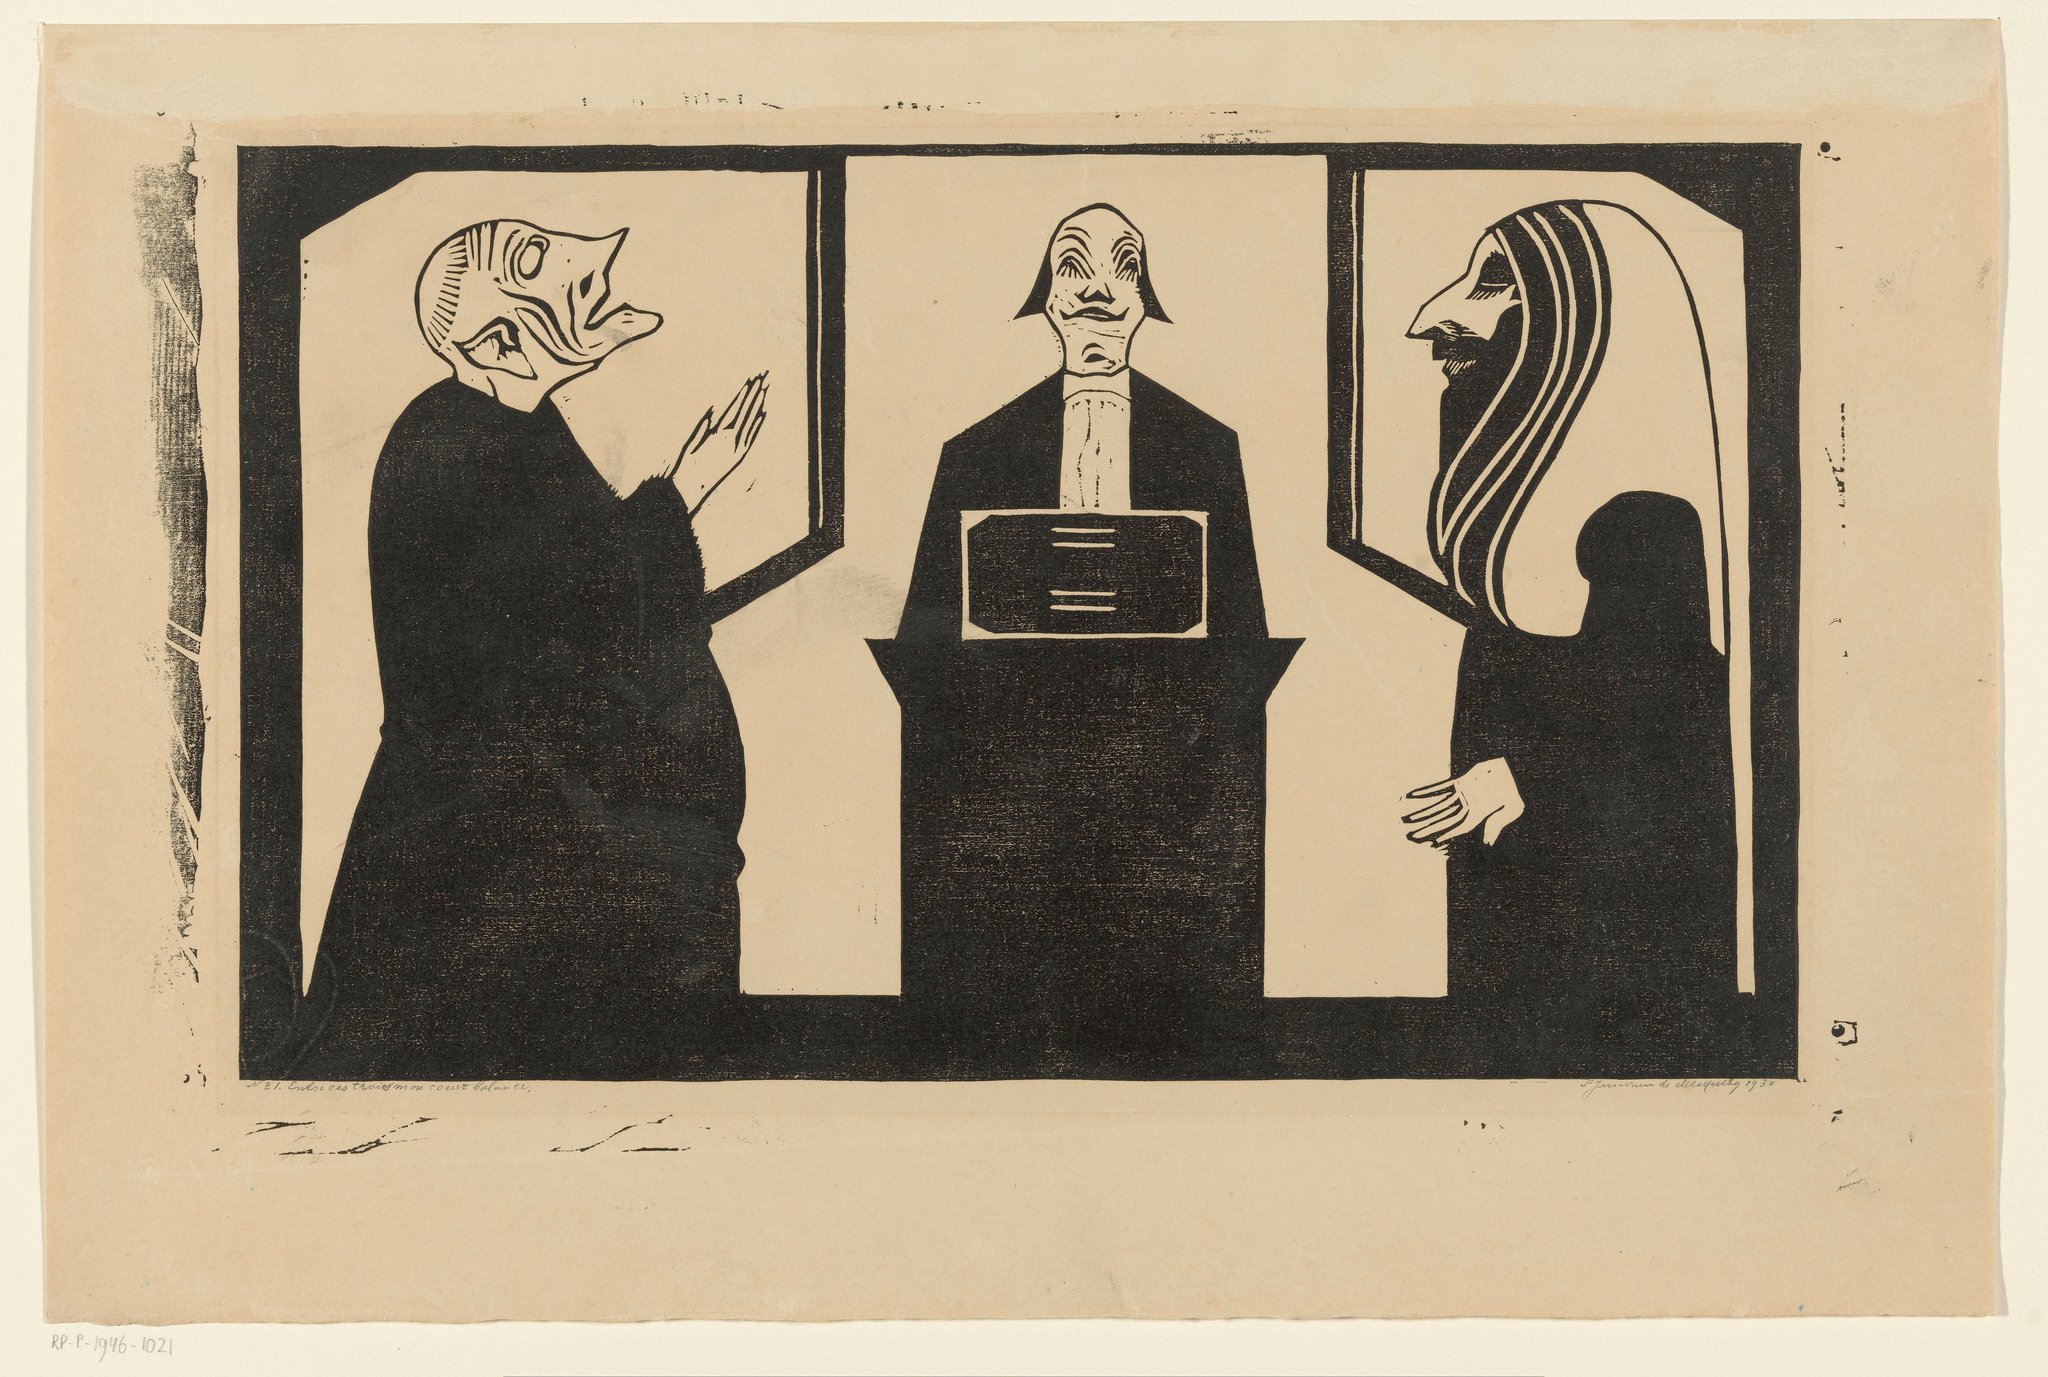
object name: print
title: Entre ces trois mon coeur balance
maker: samuel jessurun de mesquita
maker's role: draughtsman, print maker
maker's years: 1868-1944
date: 1930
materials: paper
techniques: woodcut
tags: head-gear: hood, old man, speaking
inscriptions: number: ‘No 1’, collector's mark: Lugt 2760, watermark, collector's mark: Lugt 2228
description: In het midden een man achter een lessenaar. Links een kale man die omhoog kijkt; rechts een man met een kap en gesloten ogen.